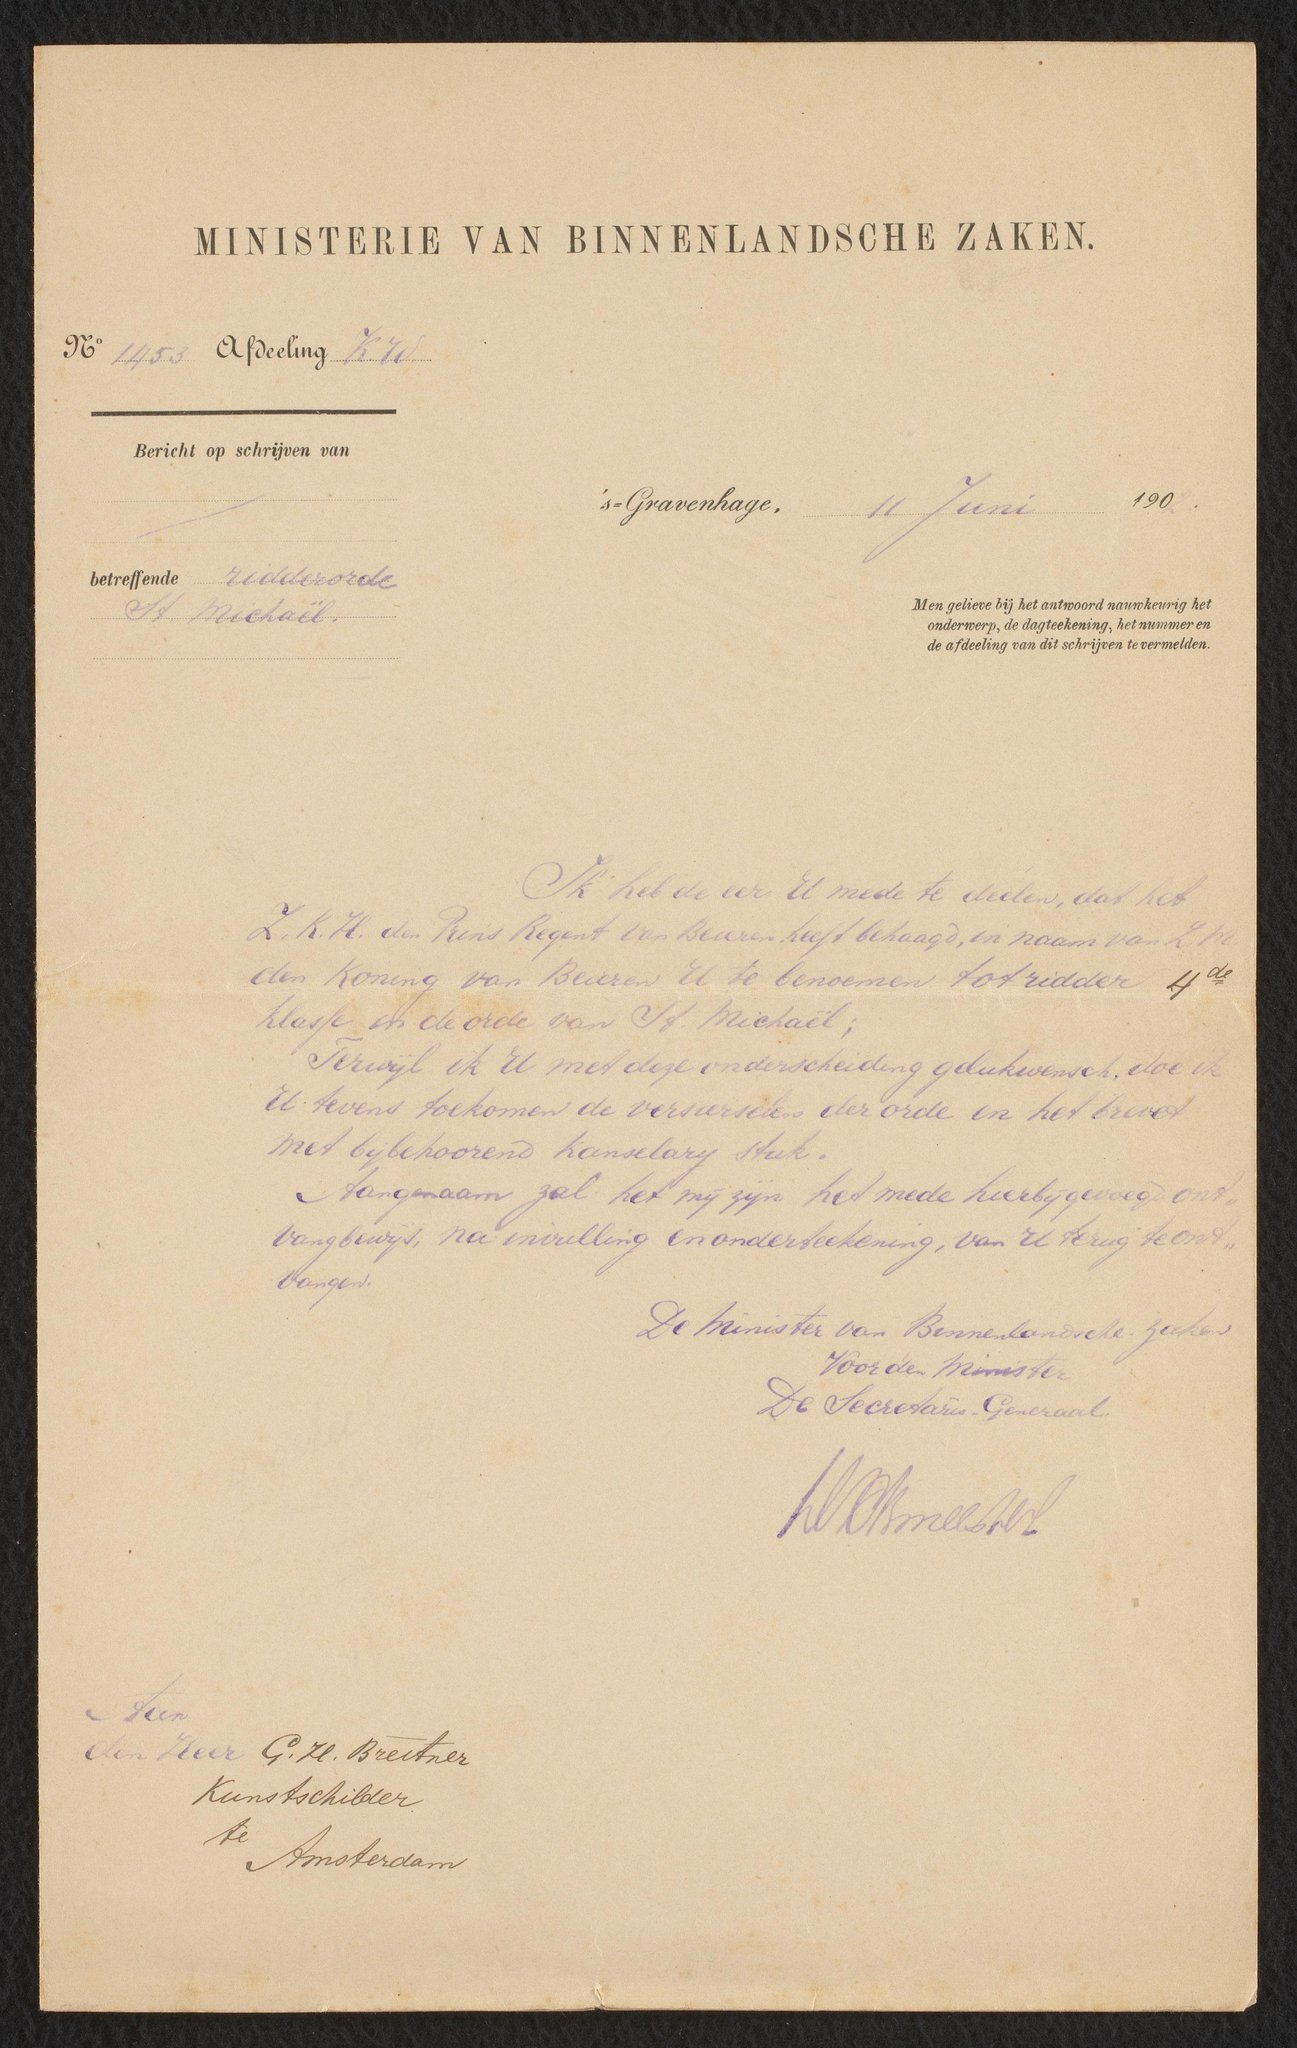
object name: letter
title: Brief gericht aan George Hendrik Breitner met bijgaand de versierselen behorende bij ridder vierde klasse in de Orde van de Heilige Michael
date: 1902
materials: ink, paper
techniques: letterpress printing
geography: the hague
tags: rotterdam, amsterdam, painter, print maker, draughtsman, george hendrik breitner, distribution of awards ~ art contest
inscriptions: inscription: ‘ord v versierselen/ H Michael in/ IV [...]/ 1902’